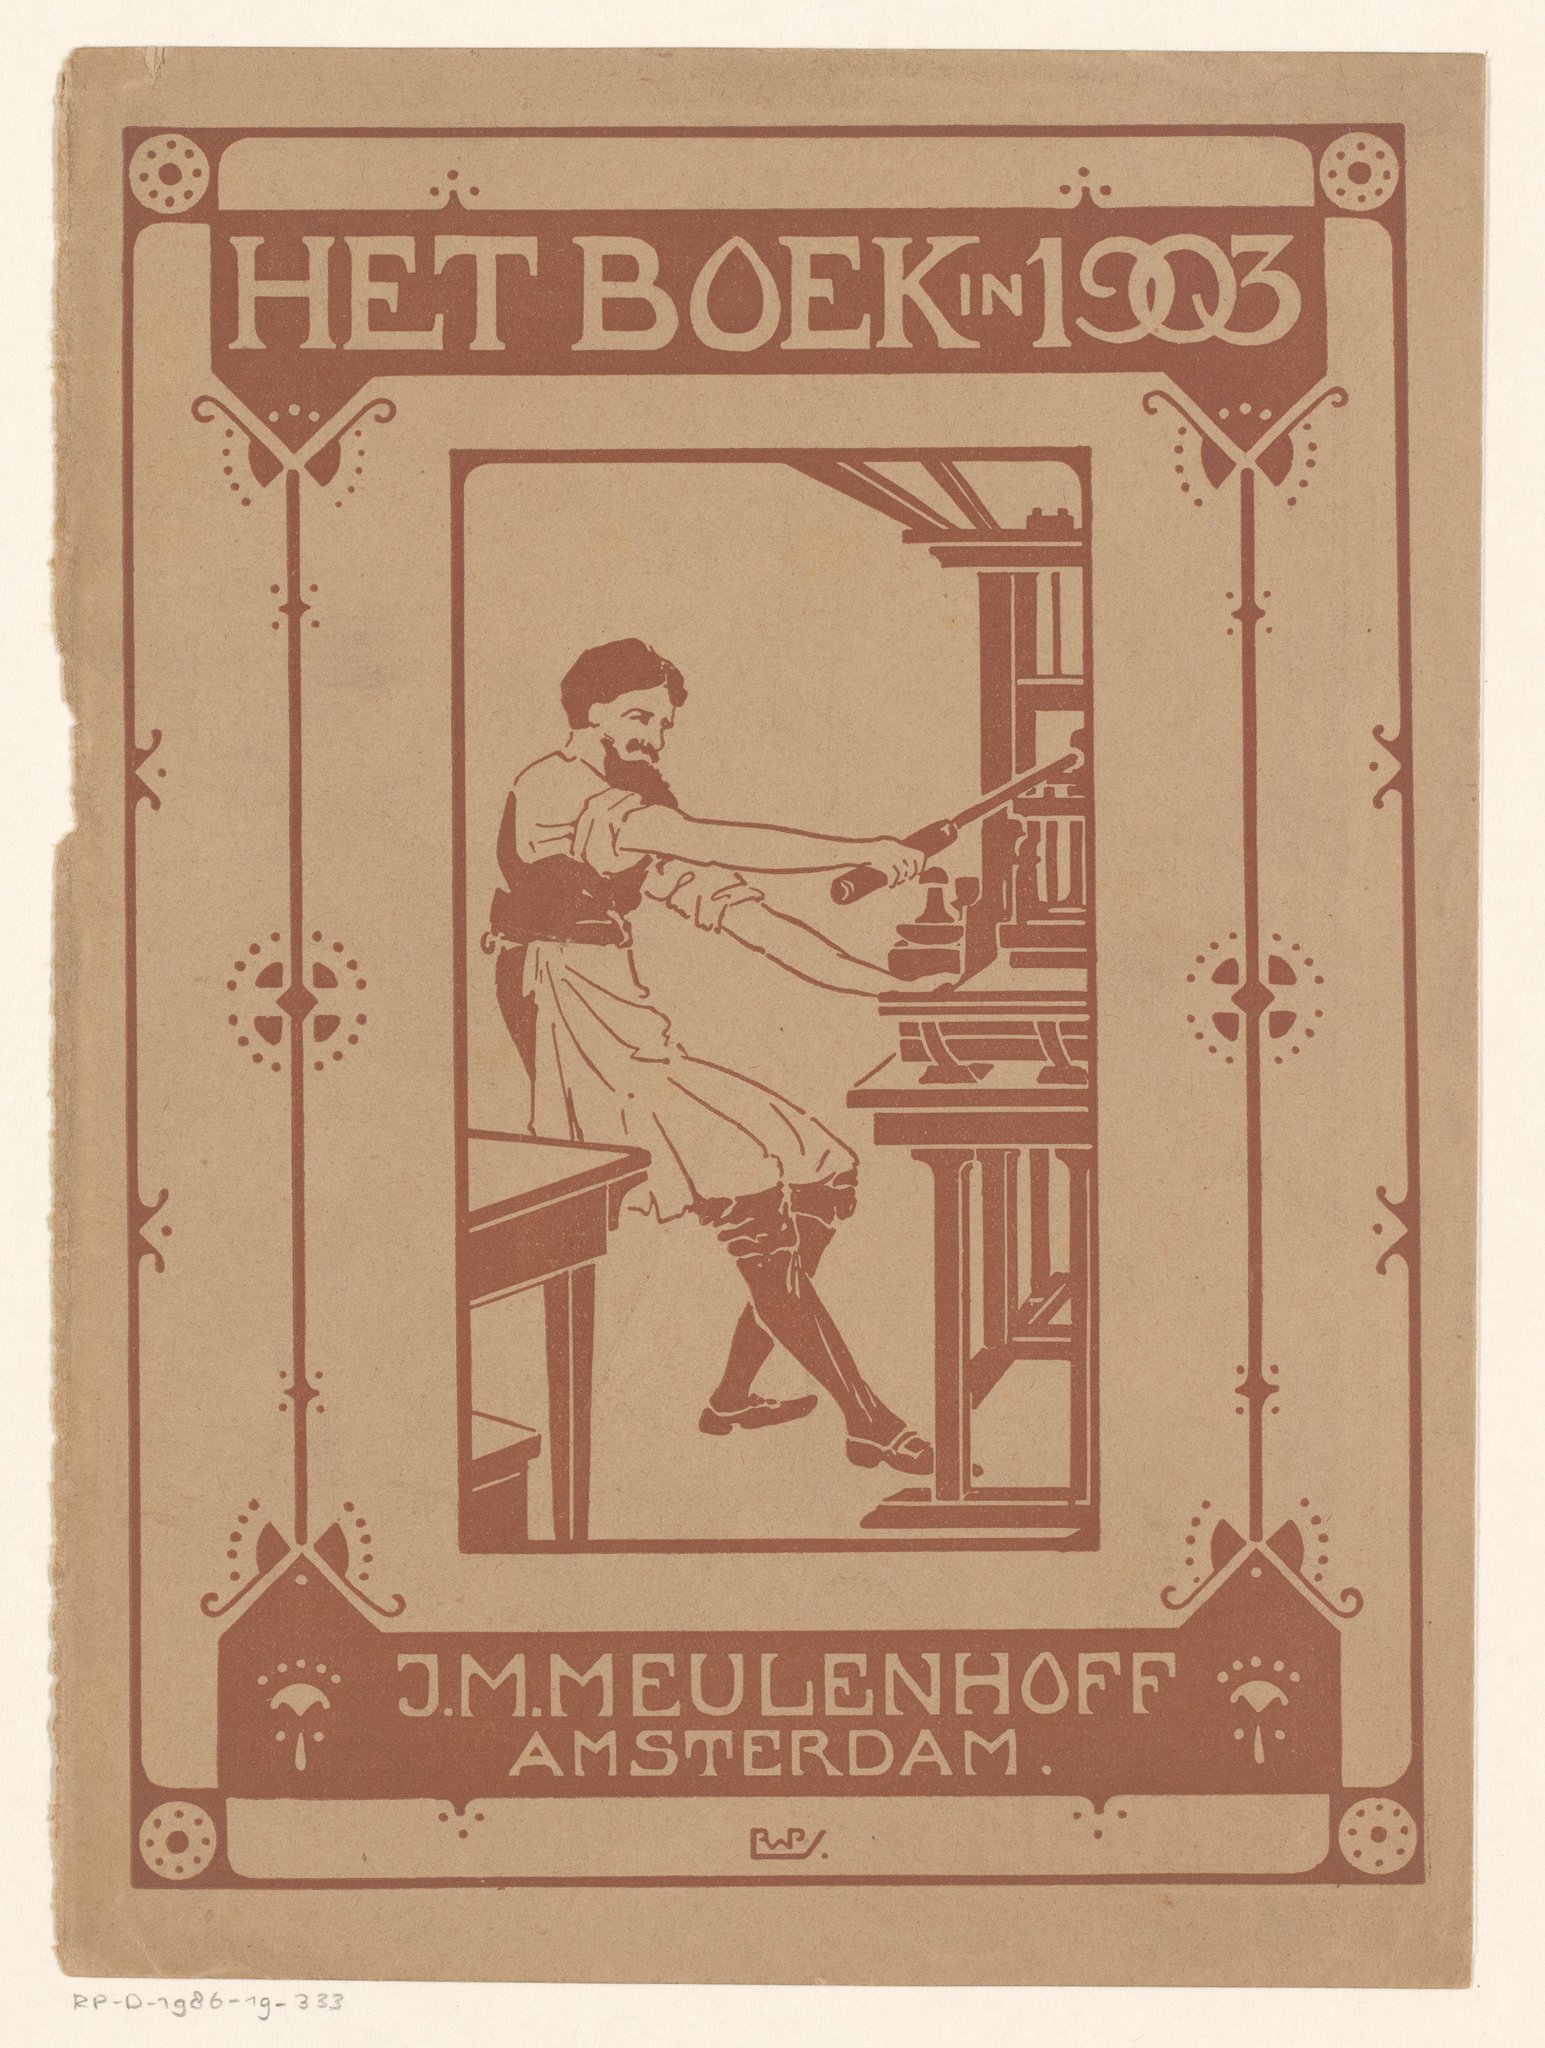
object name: photomechanical print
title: Omslag van: Het boek in 1903, 1903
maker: reinier willem petrus de vries (1874-1953)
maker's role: draughtsman, print maker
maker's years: 1874-1953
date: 1903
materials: paper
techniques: printing block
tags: printing press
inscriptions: collector's mark: ‘R:MVS.’